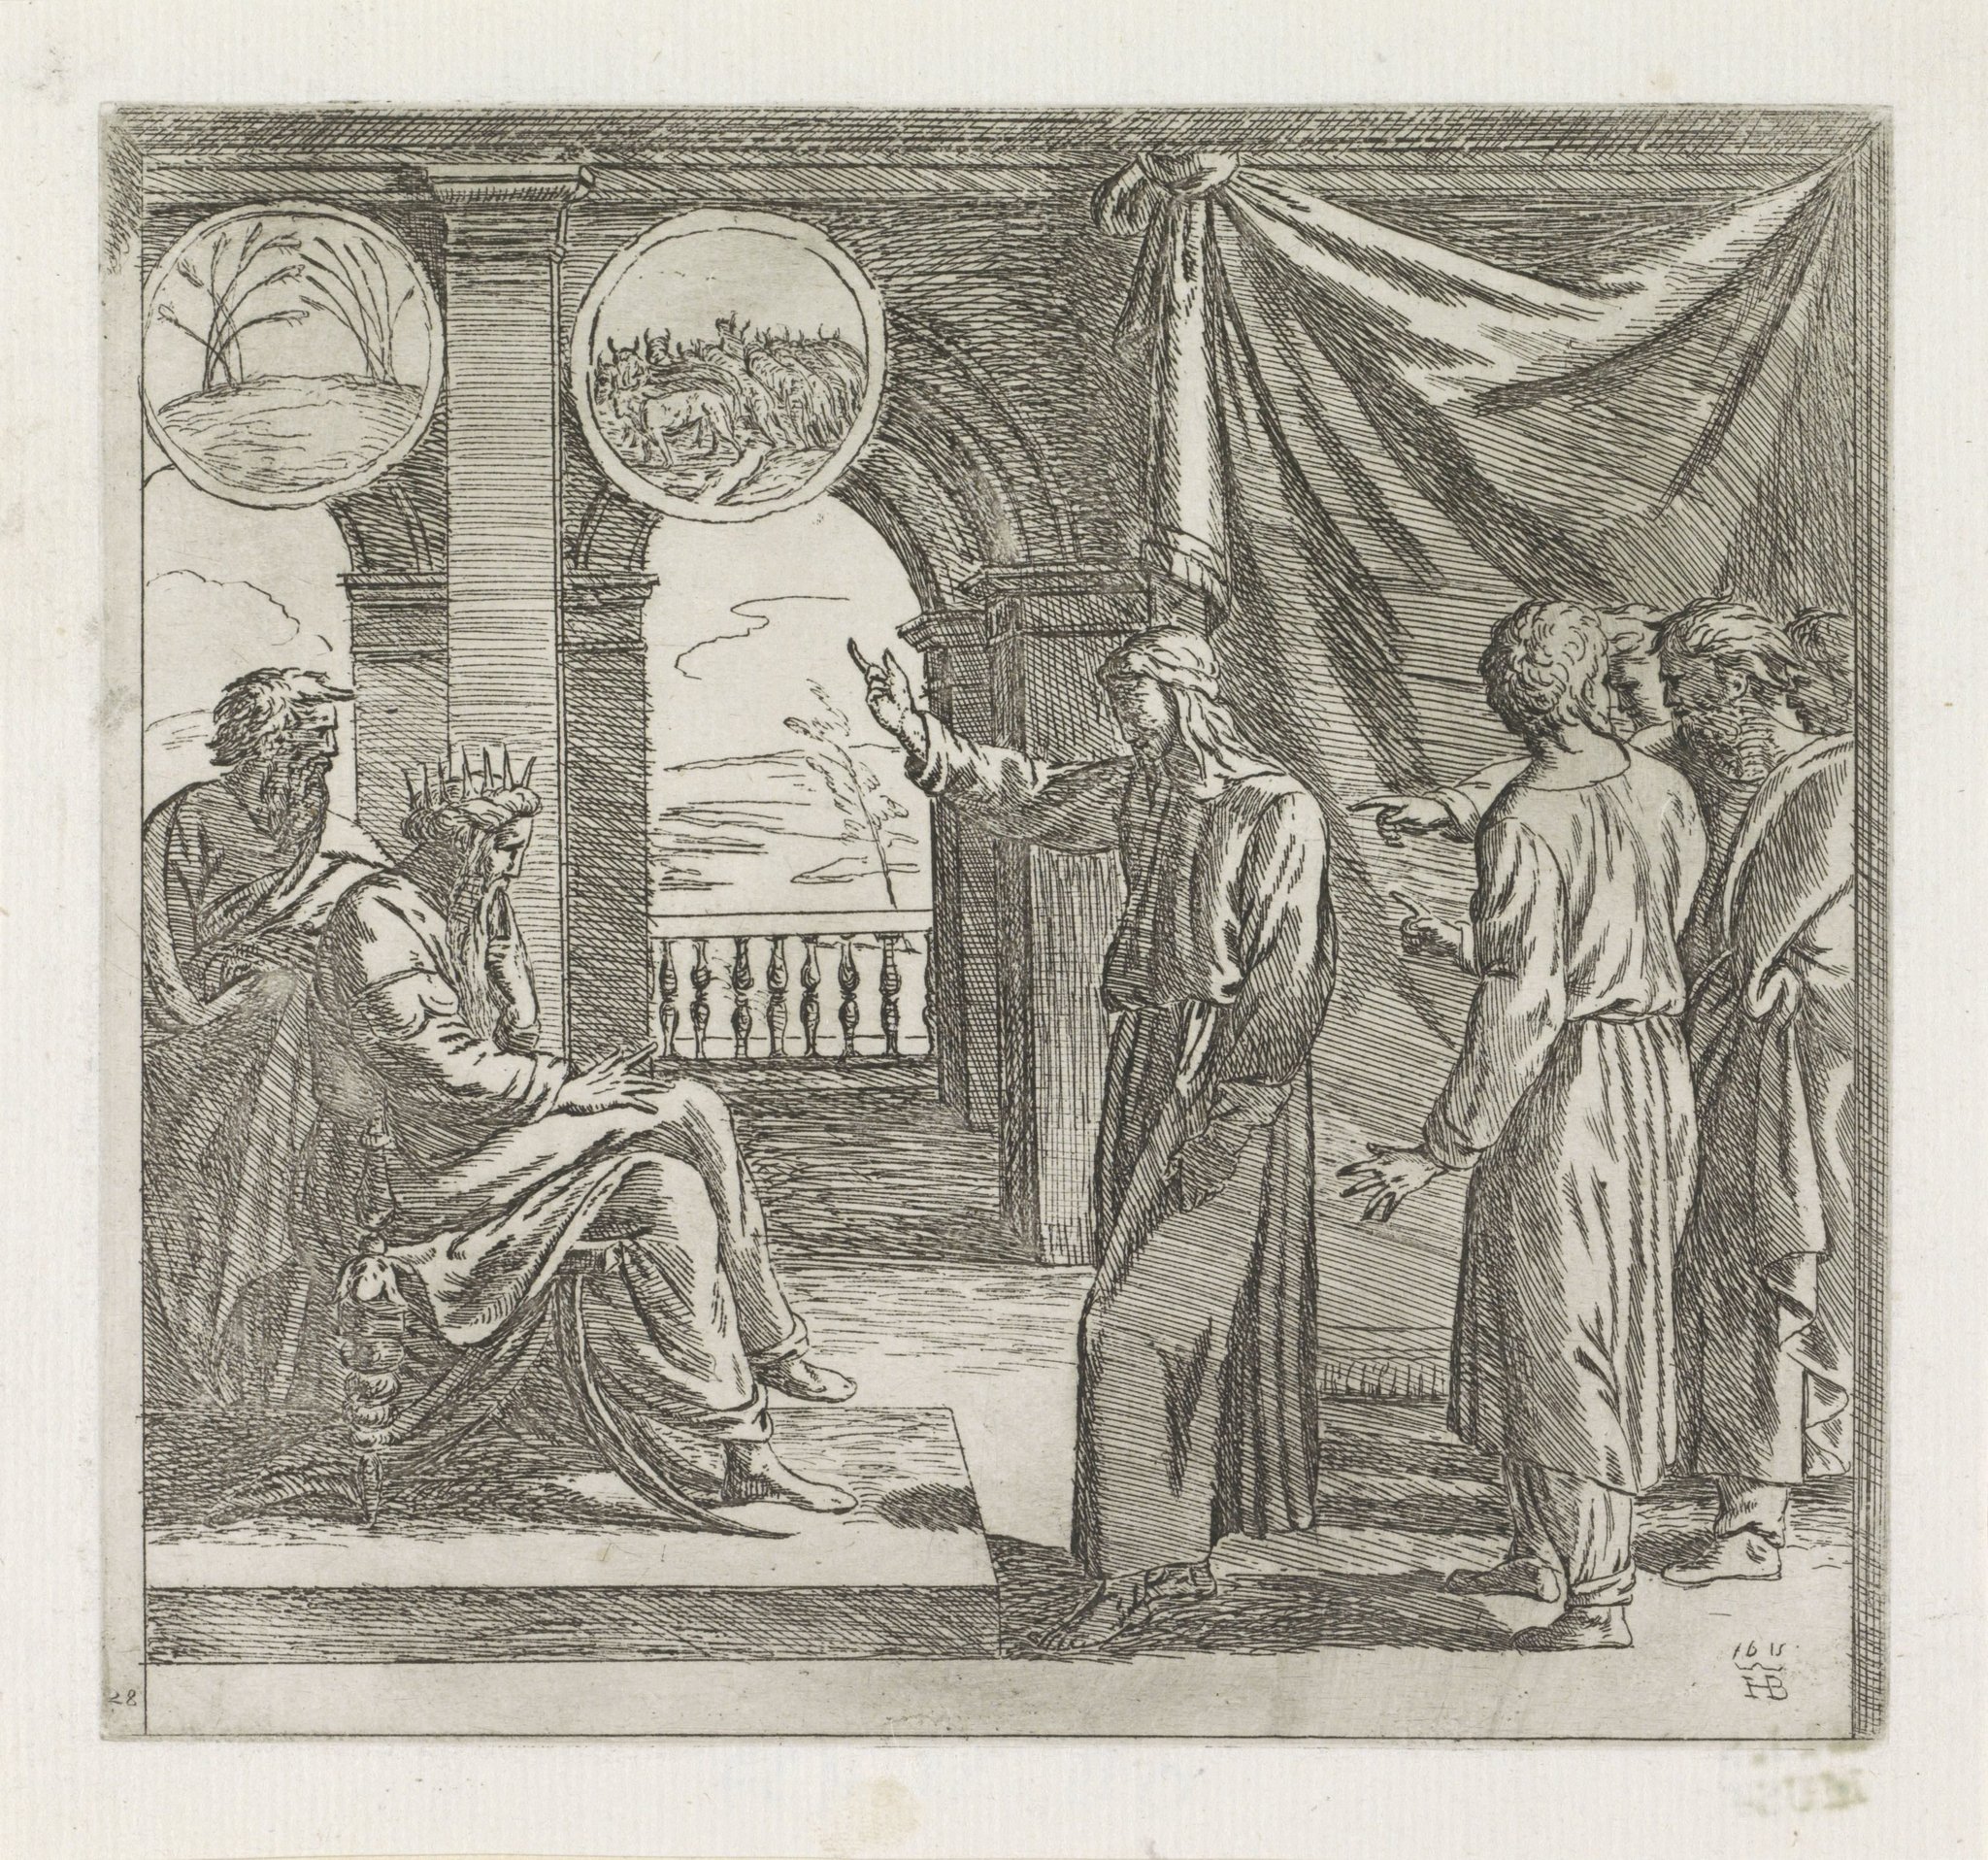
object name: print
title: Schilderingen in de Loggia van Rafaël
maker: orazio borgianni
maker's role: print maker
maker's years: 1578-1616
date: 1615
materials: paper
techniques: etching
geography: vatican city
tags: joseph interpreting pharaoh's dreams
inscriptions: collector's mark: Lugt 2165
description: Links zit de farao op zijn troon. Rechts staat Jozef die de dromen van de farao uitlegt. Achter Jozef staat een groepje mannen.